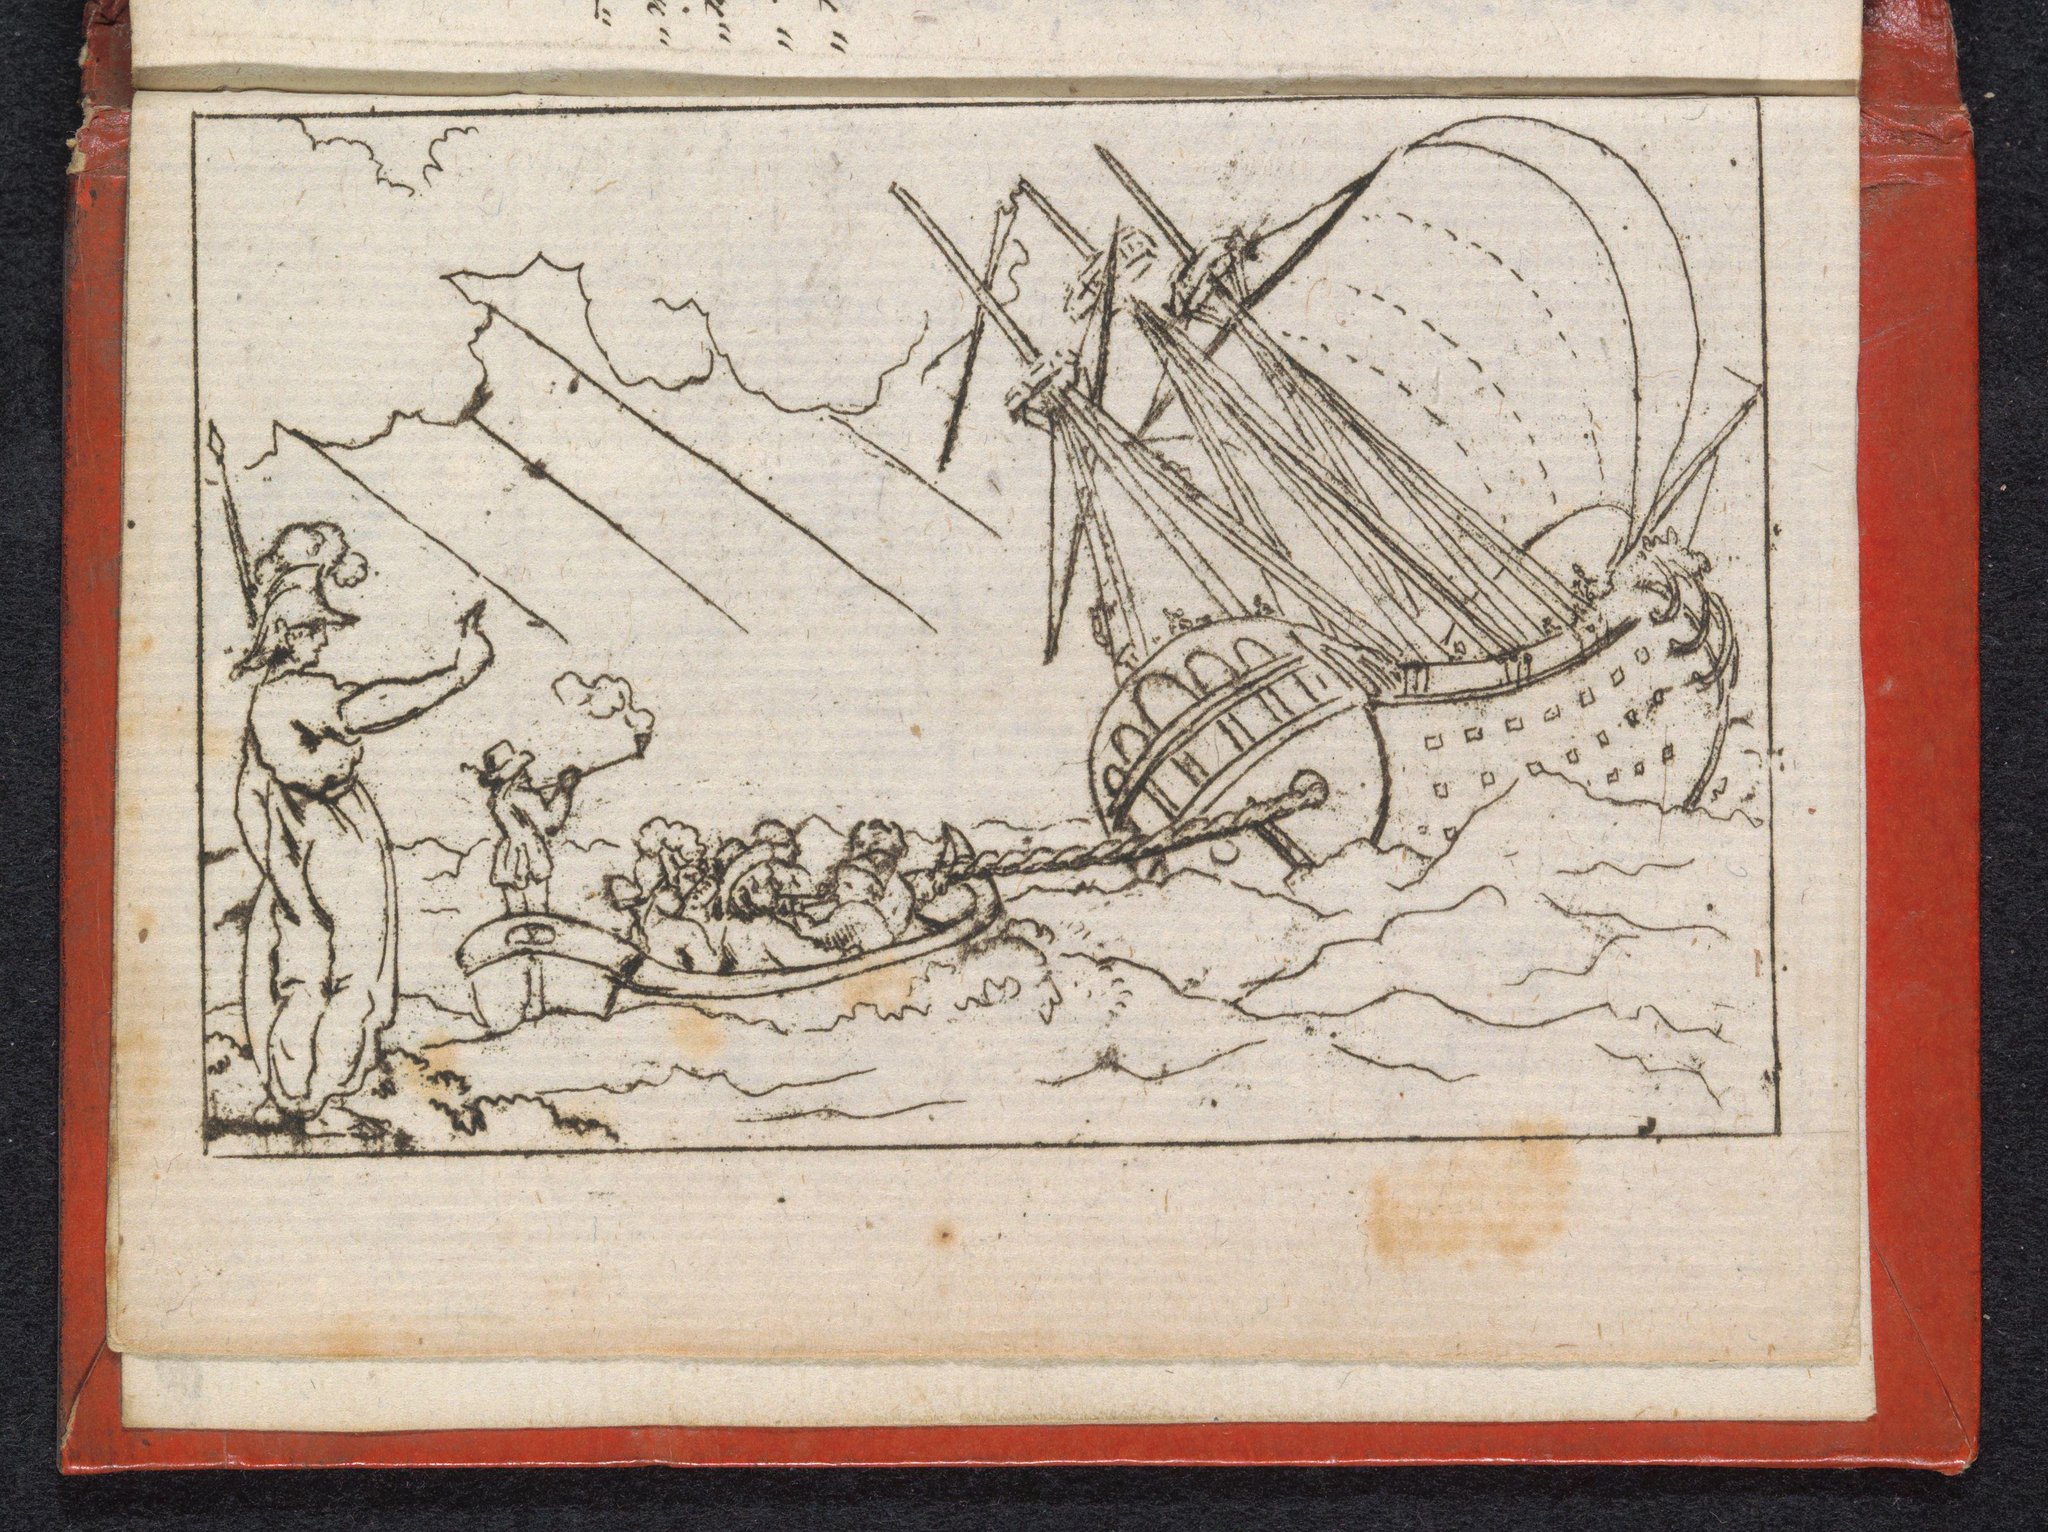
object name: print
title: De Nederlandse Maagd en het Schip van Staat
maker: pieter van woensel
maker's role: print maker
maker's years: 1747-1808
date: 1797-1798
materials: paper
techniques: etching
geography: netherlands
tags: personifications of countries, nations, states, districts, etc., shipwreck, netherlands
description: De Nederlandse Maagd ziet staande op de kust hoe het ontredderde Nederlandse Schip van Staat door een sloep op sleeptouw wordt genomen. Illustratie in Pieter van Woensels almanak 'De Lantaarn voor 1798'.